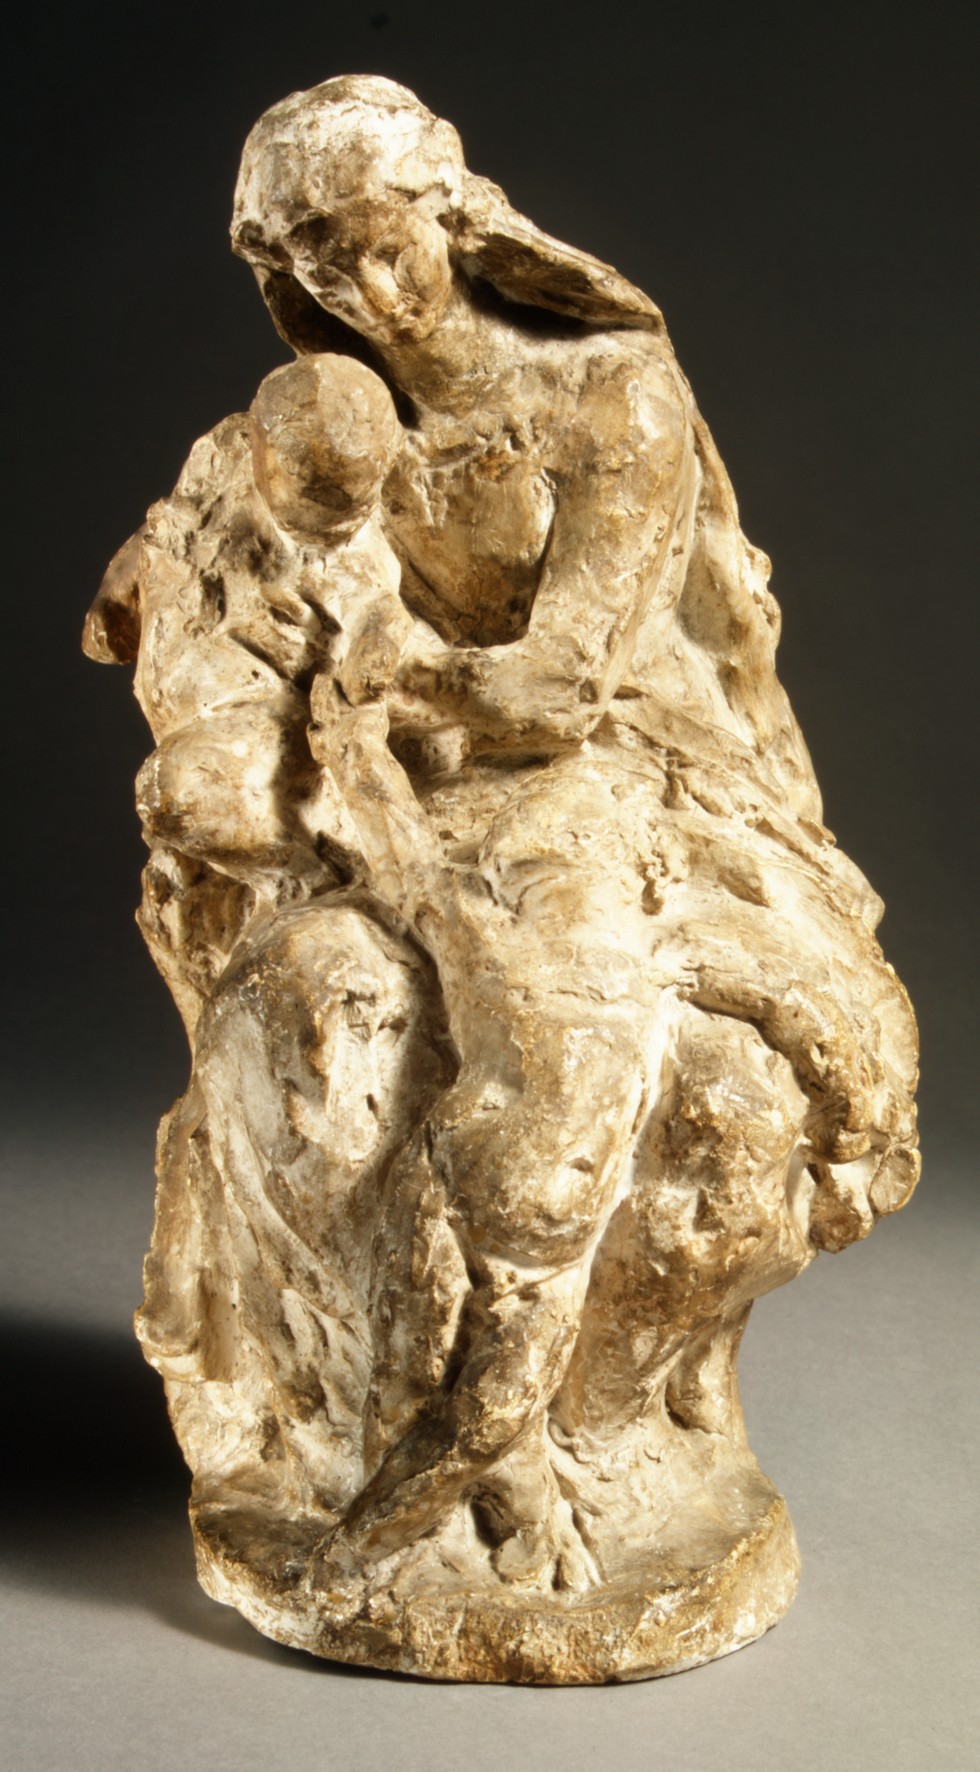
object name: statuette group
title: Virgin and Child with St. John the Baptist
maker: jean-baptiste carpeaux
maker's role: maker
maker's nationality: french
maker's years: 1827-1875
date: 1801-1900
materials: plaster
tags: madonna and child